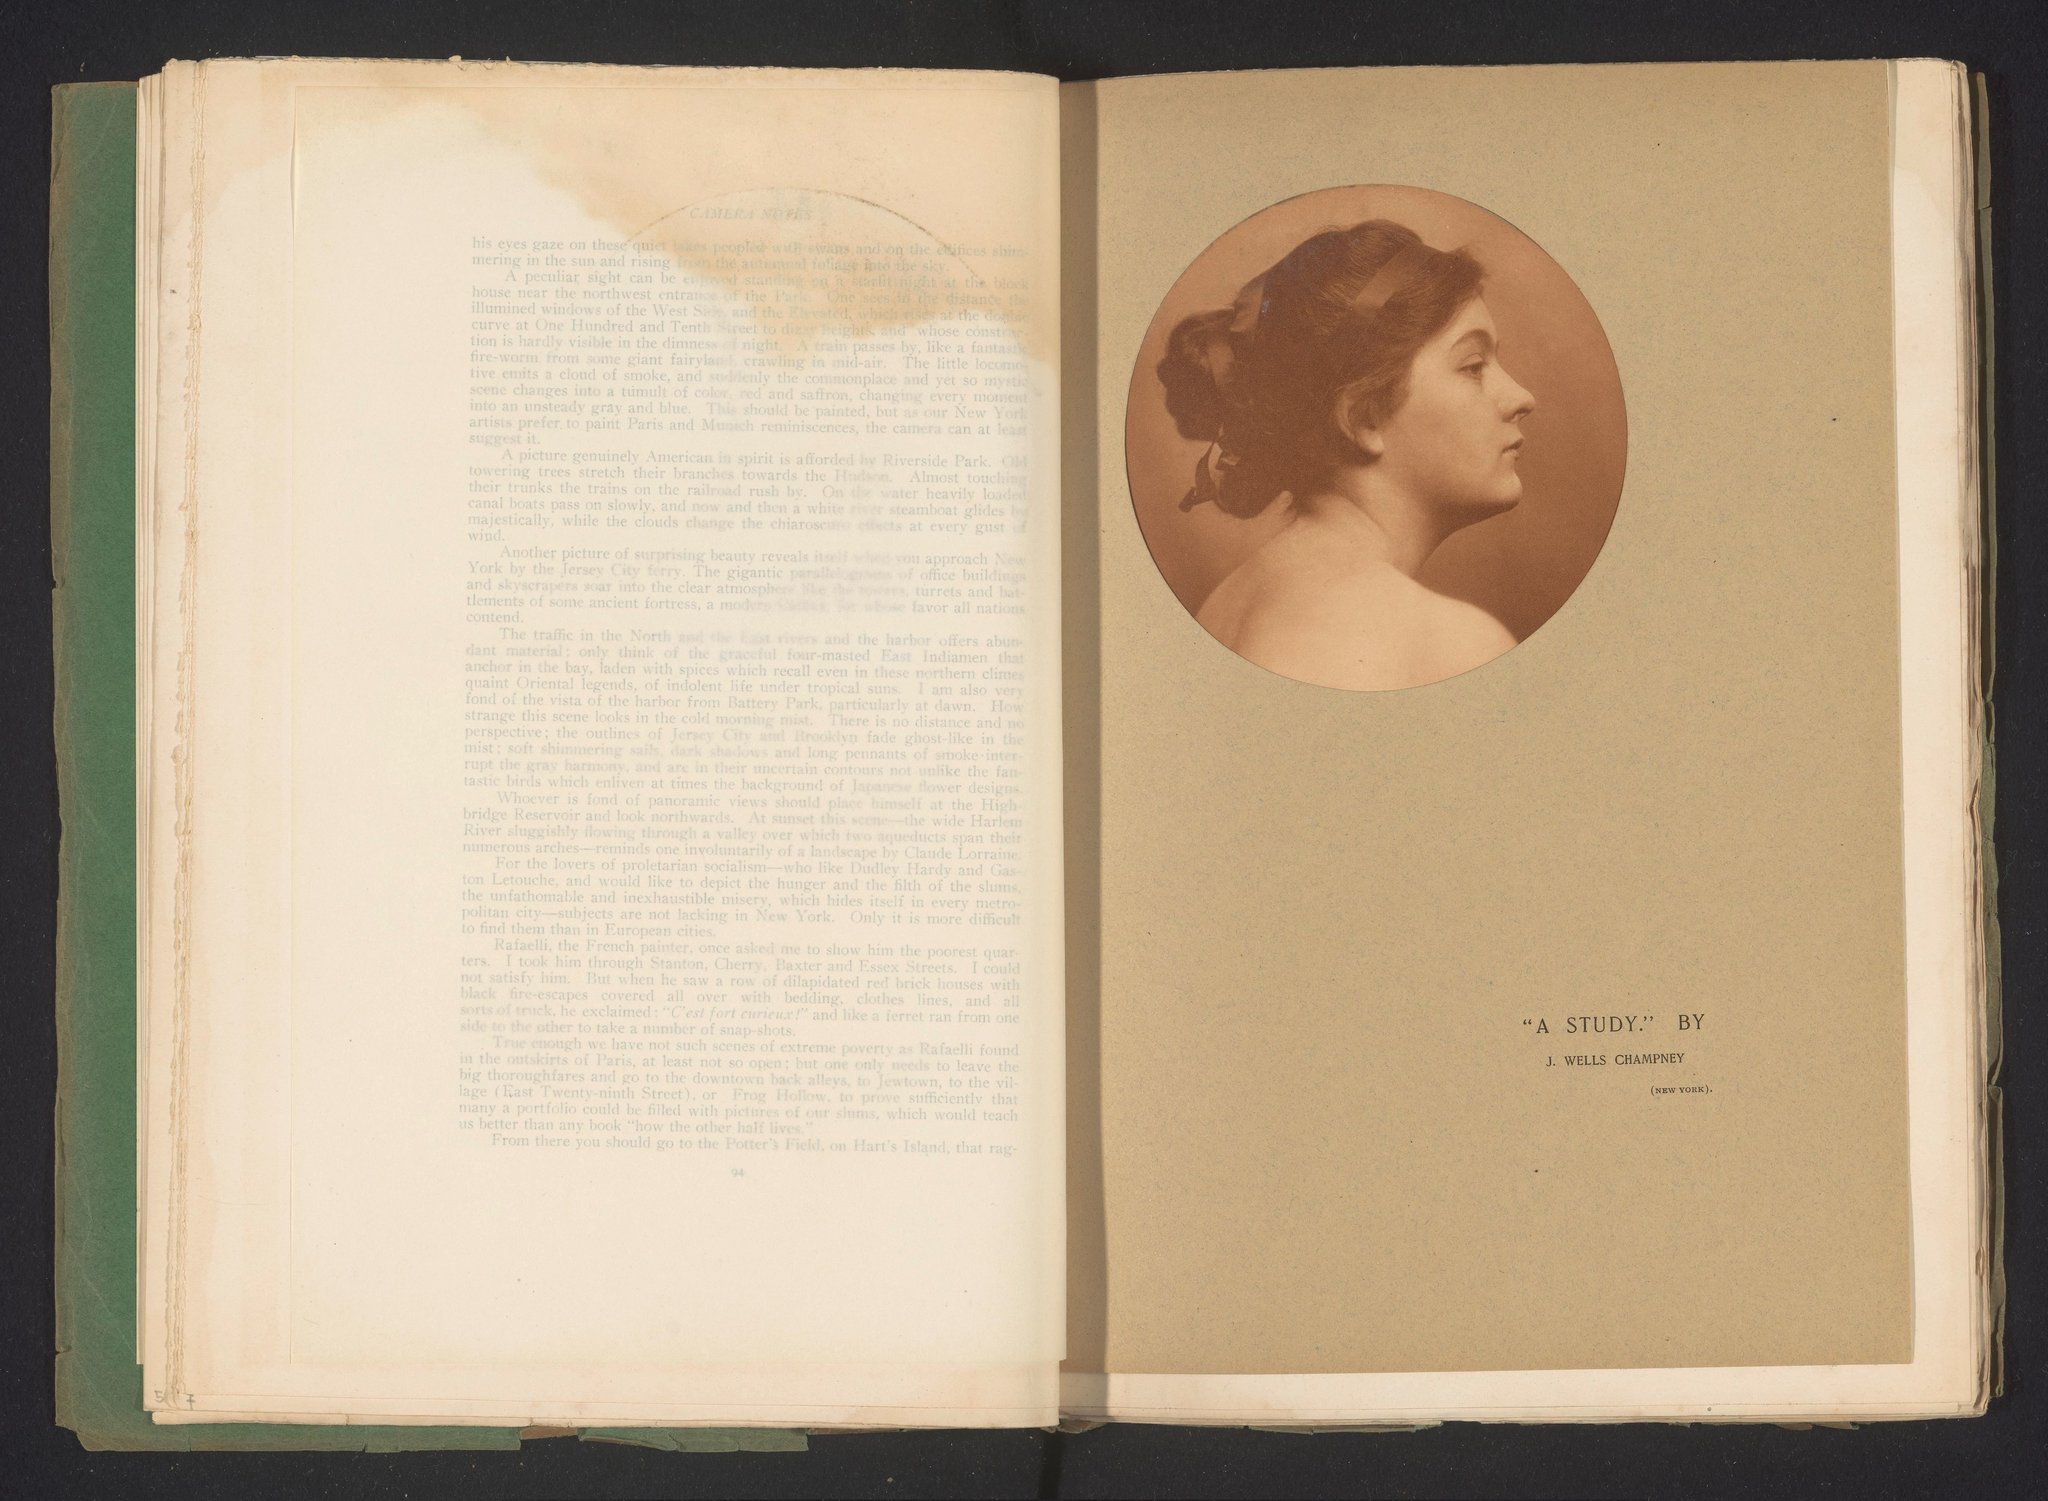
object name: photomechanical print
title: Portret van een onbekende vrouw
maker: james wills champney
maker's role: painter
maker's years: 1843-1903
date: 1895-1900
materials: paper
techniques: photoaquatint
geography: new york city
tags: historical persons not known by name - bb - woman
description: Prent tegenover pagina 94, achter semi-transparante omslag.